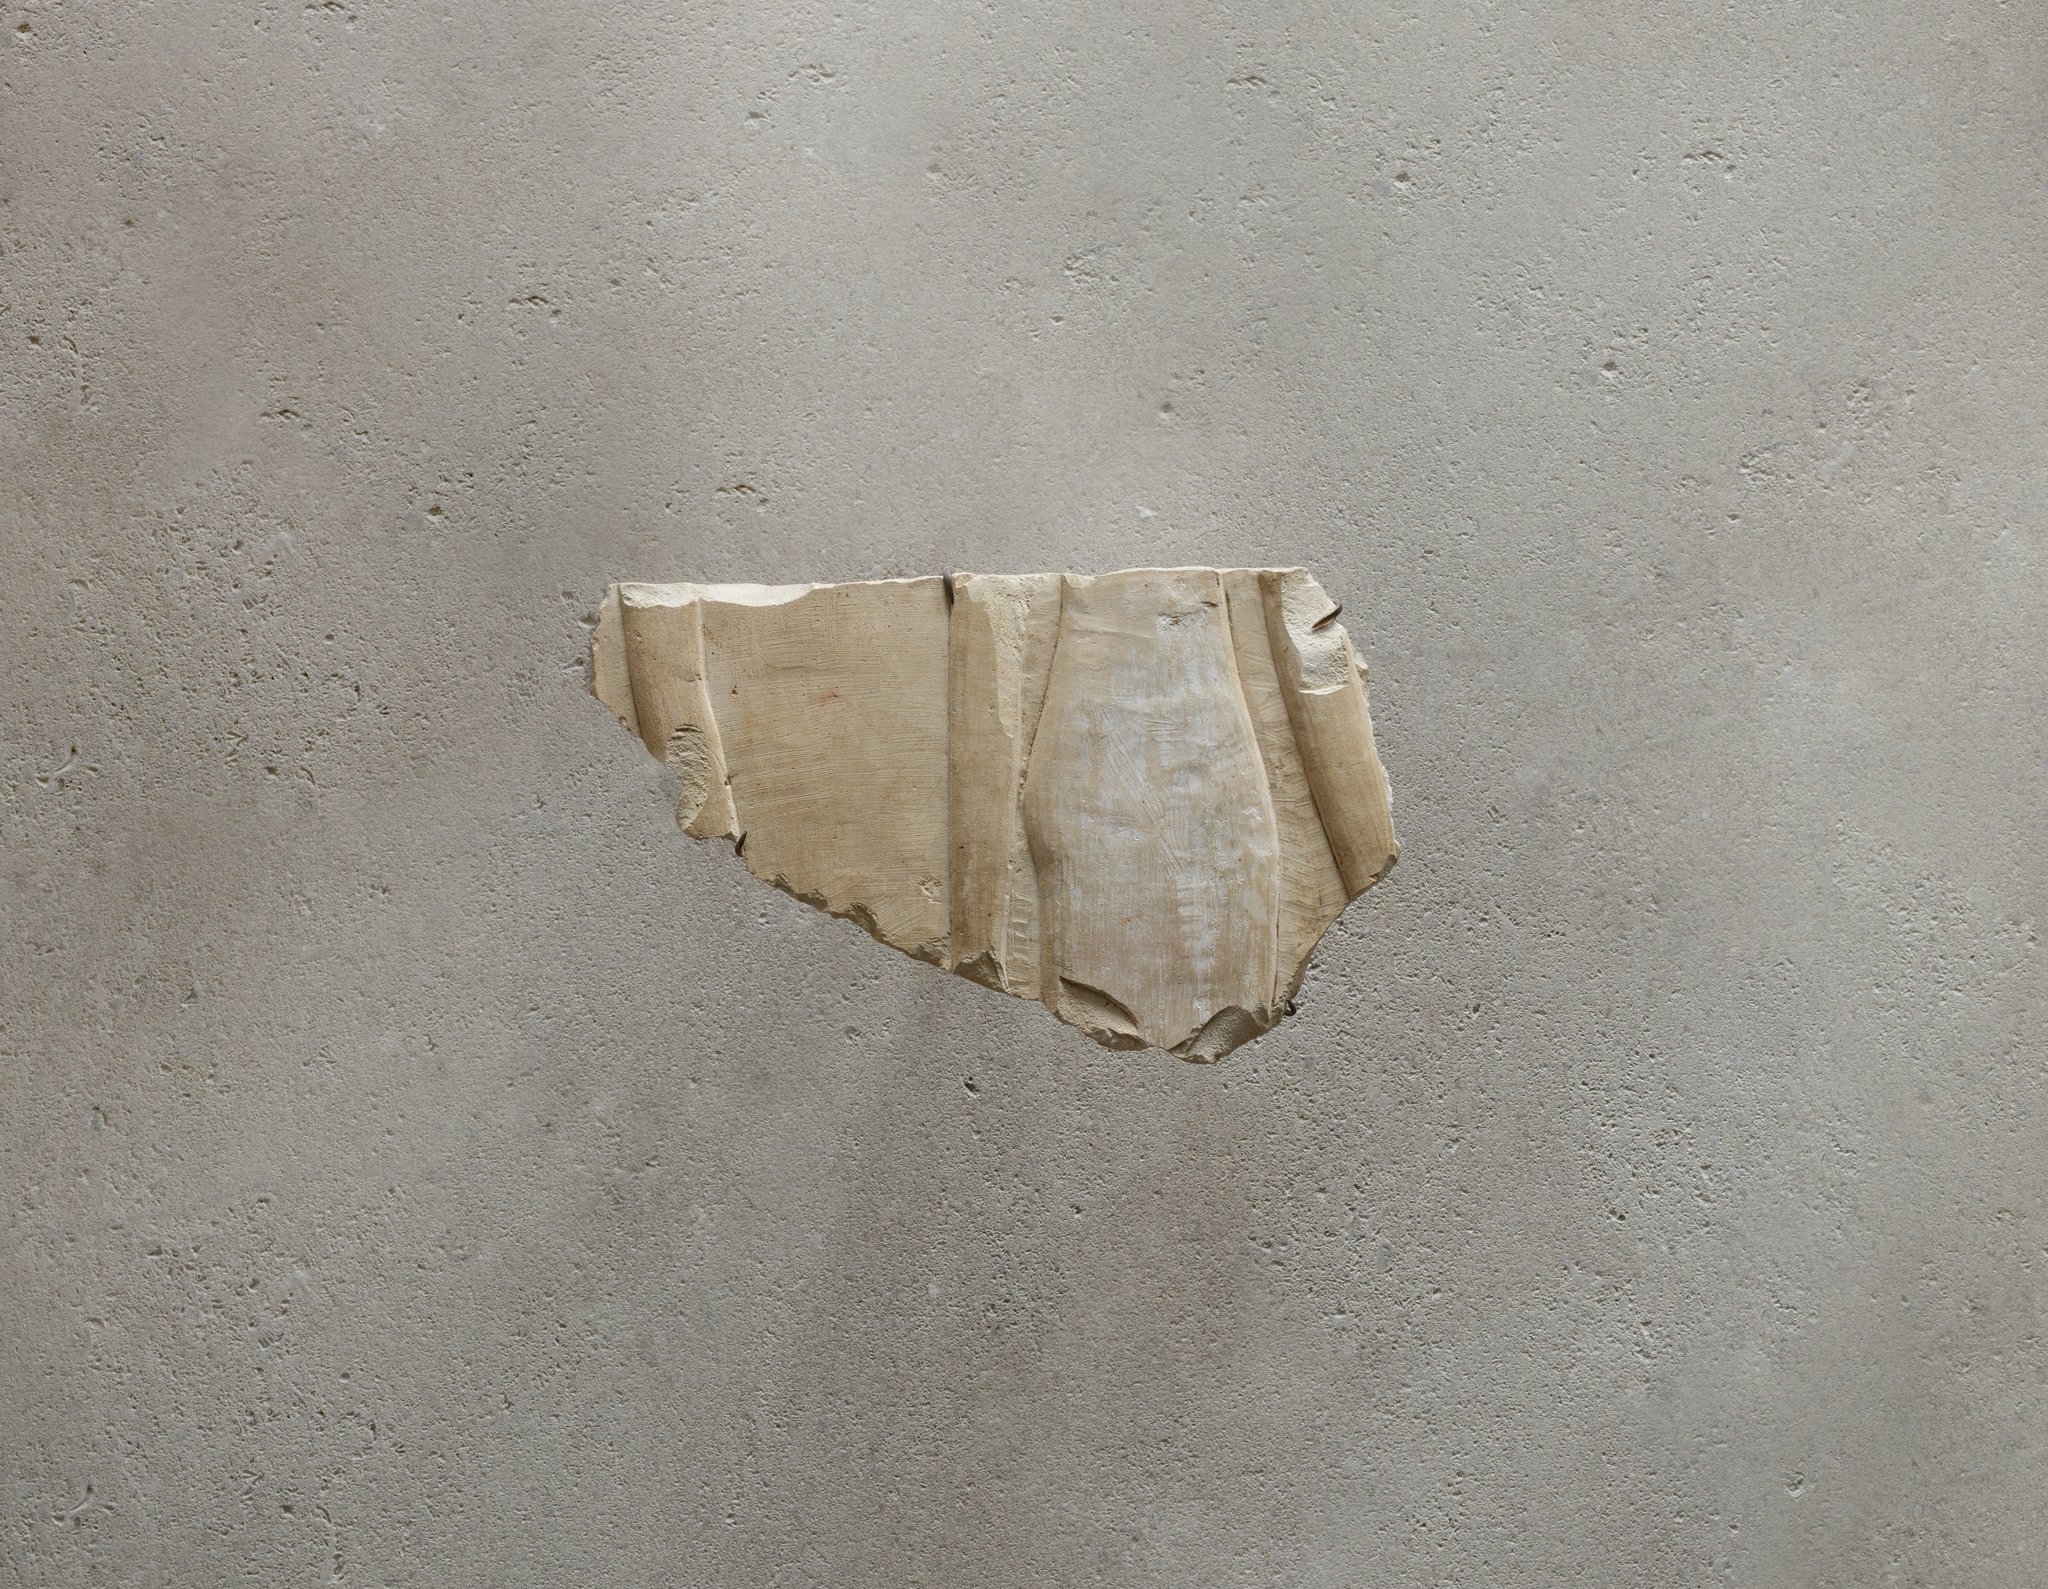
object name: relief, part of female attendant, neferu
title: Relief from the tomb of Queen Neferu: parts of two female attendants (see 26.3.353-1)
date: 2051-2030 BCE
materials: limestone, paint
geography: egypt